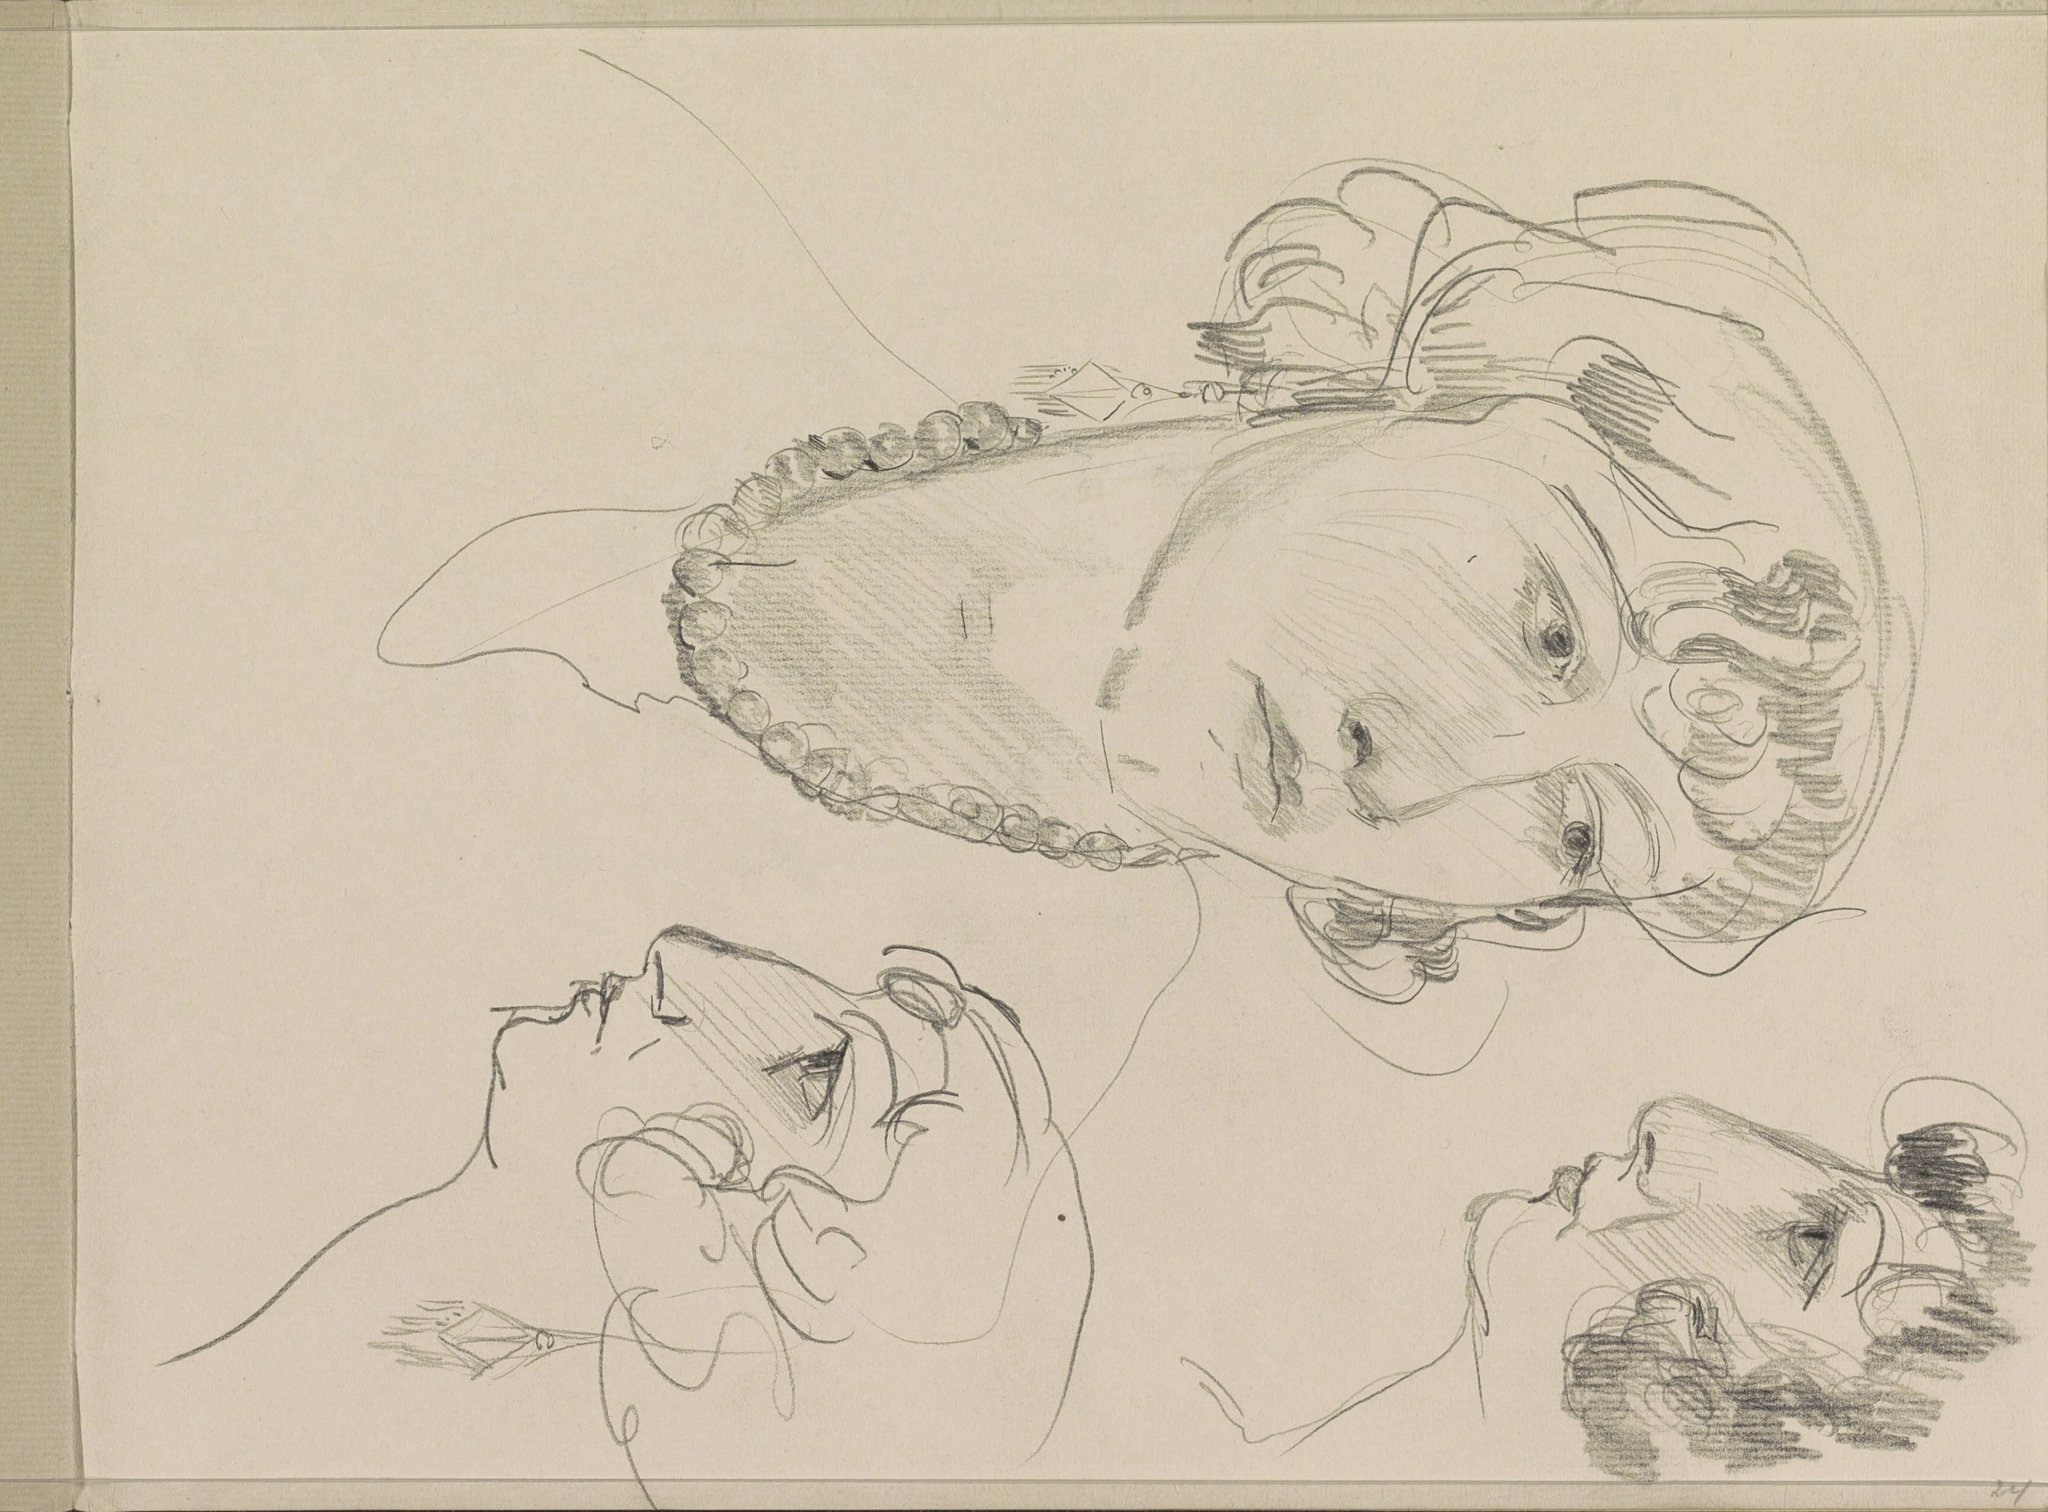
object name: sketchbook leaf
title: Studieblad met vrouwenhoofden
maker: isaac israels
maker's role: draughtsman, painter, print maker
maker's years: 1865-1934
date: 1875-1934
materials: paper, pencil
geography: the hague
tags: head (human) - aa - female human figure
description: Een vrouw met een halsketting, een andere met oorbel. Blad 24 recto uit schetsboek IV met 27 bladen.